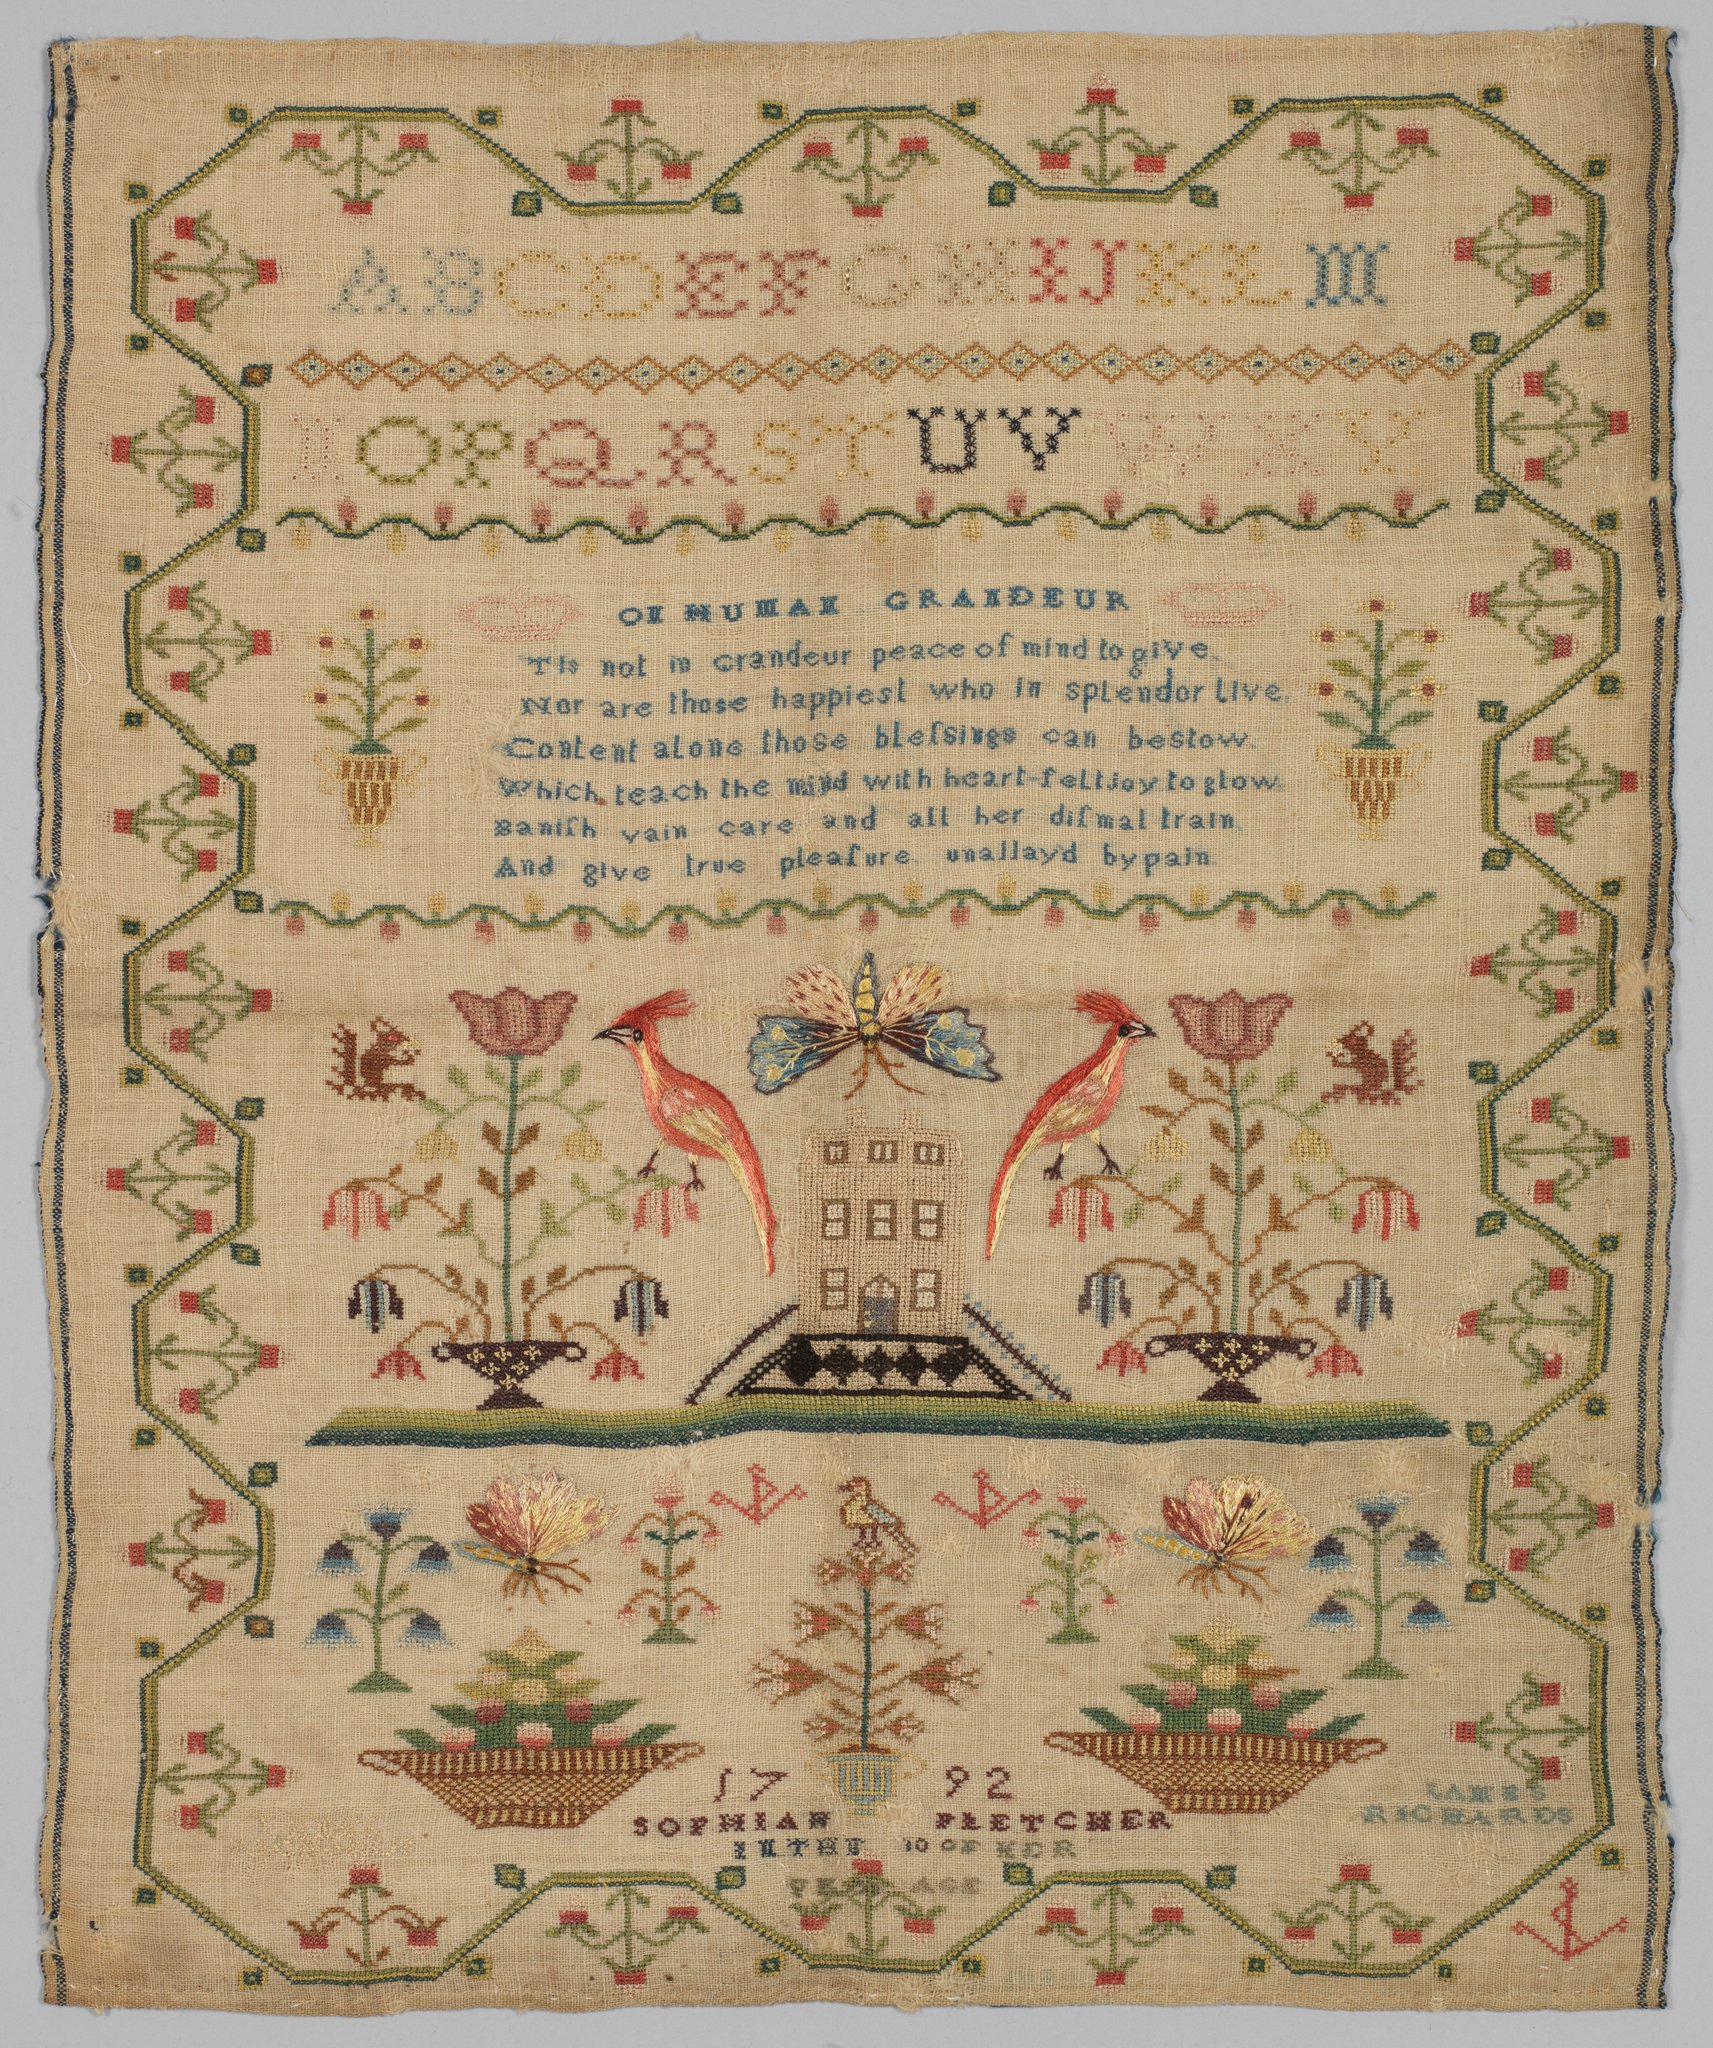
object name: sampler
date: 1792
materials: silk, wool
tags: birds,butterflies,flowers